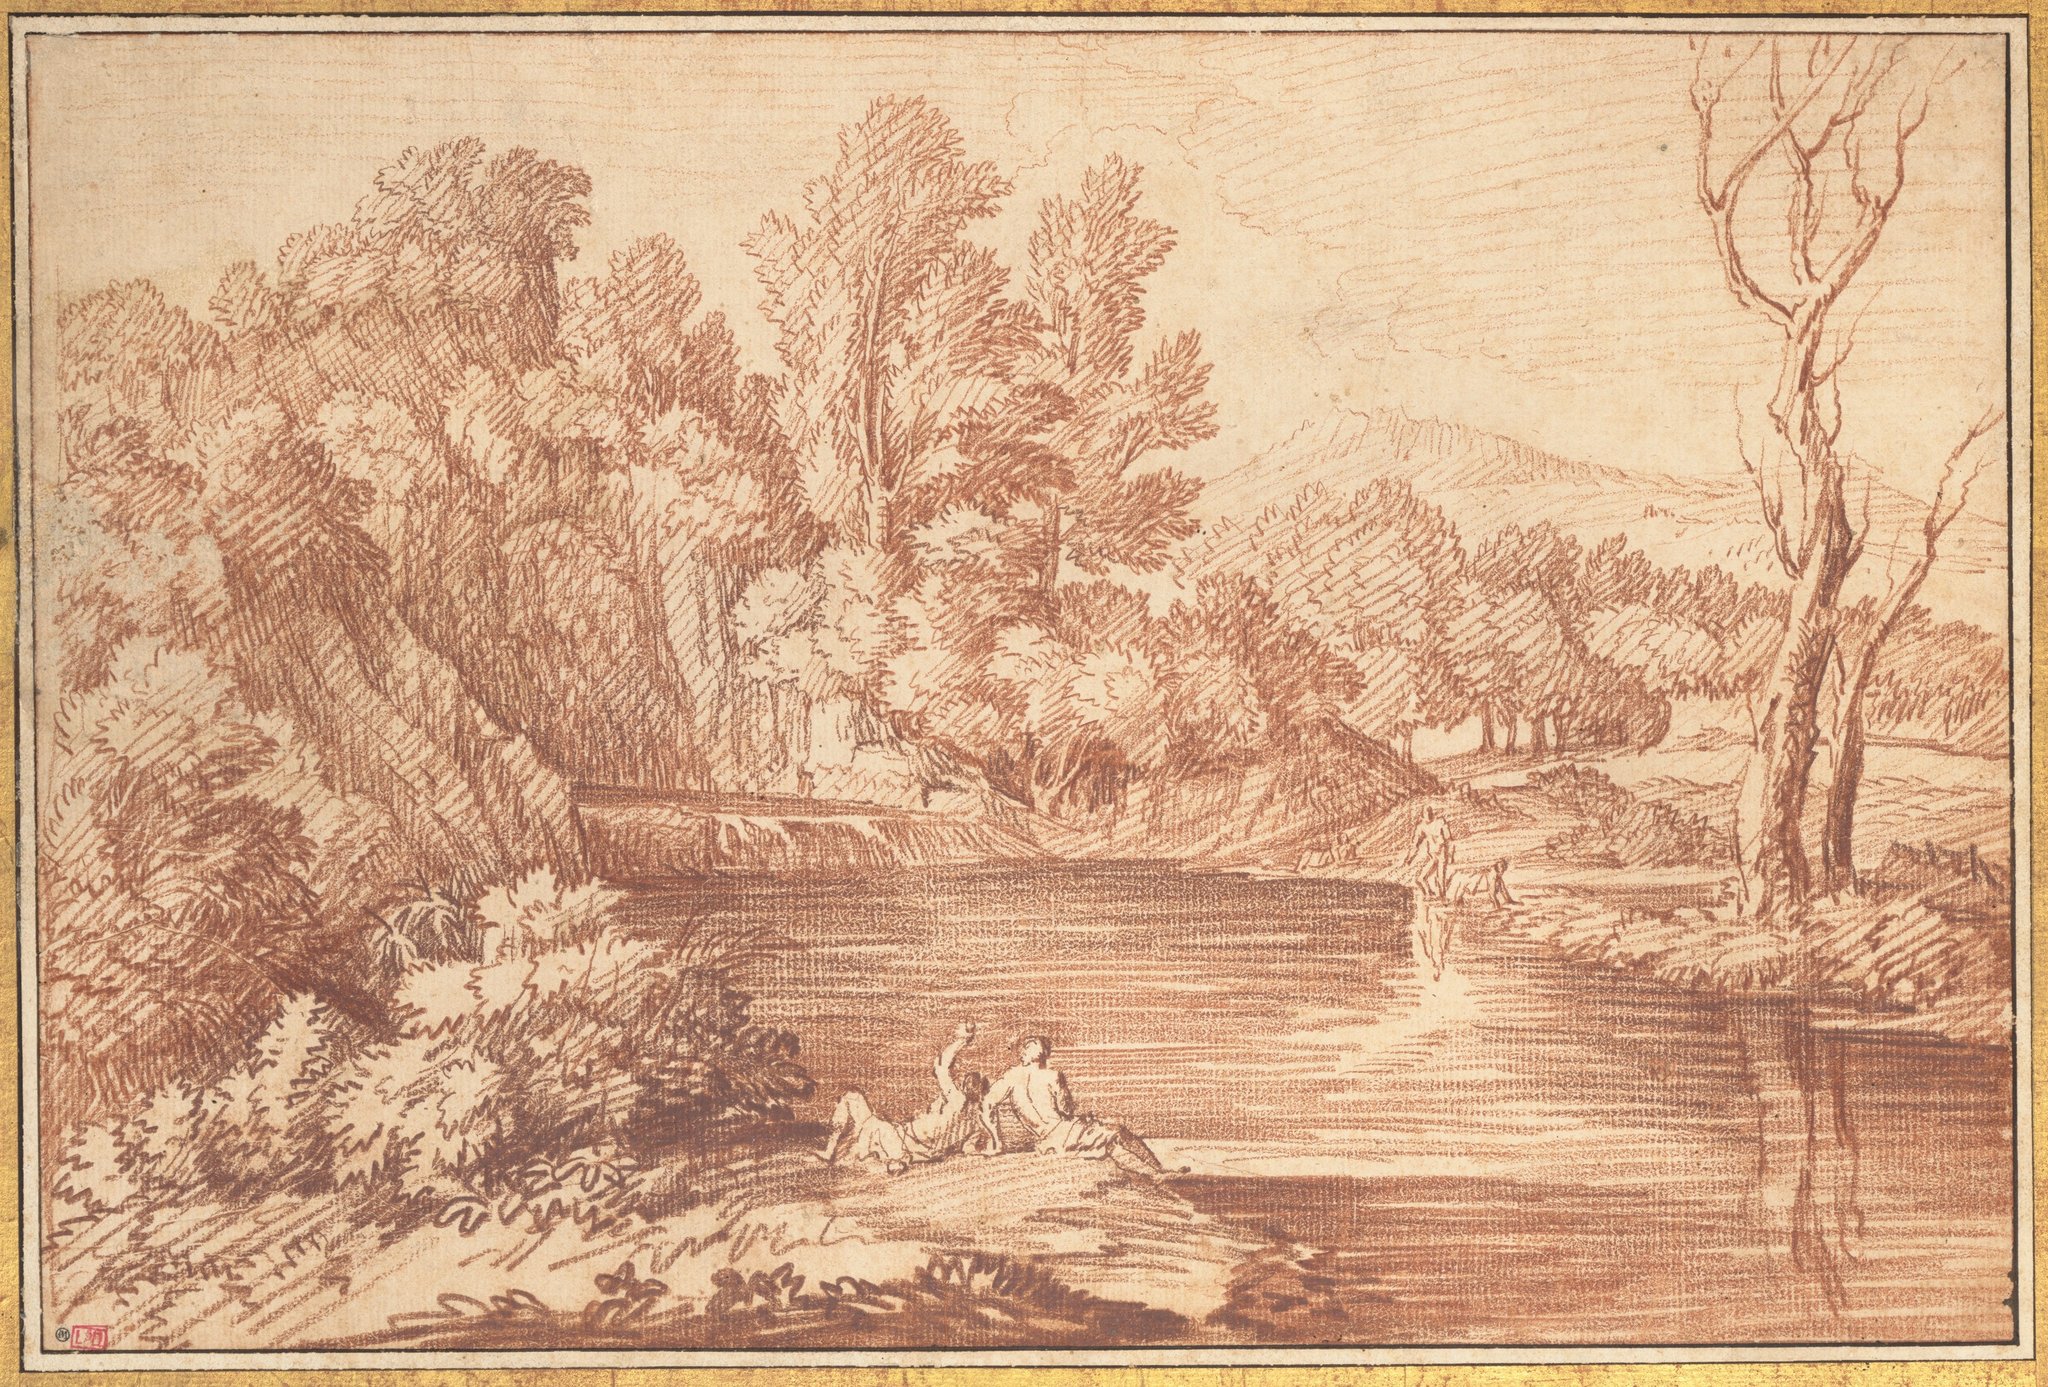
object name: drawing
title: Landscape with Figures on the Bank of a River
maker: gaspard dughet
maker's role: artist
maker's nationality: french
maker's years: 1615-1675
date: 1601-1700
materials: chalk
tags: human figures,rivers,landscapes,trees